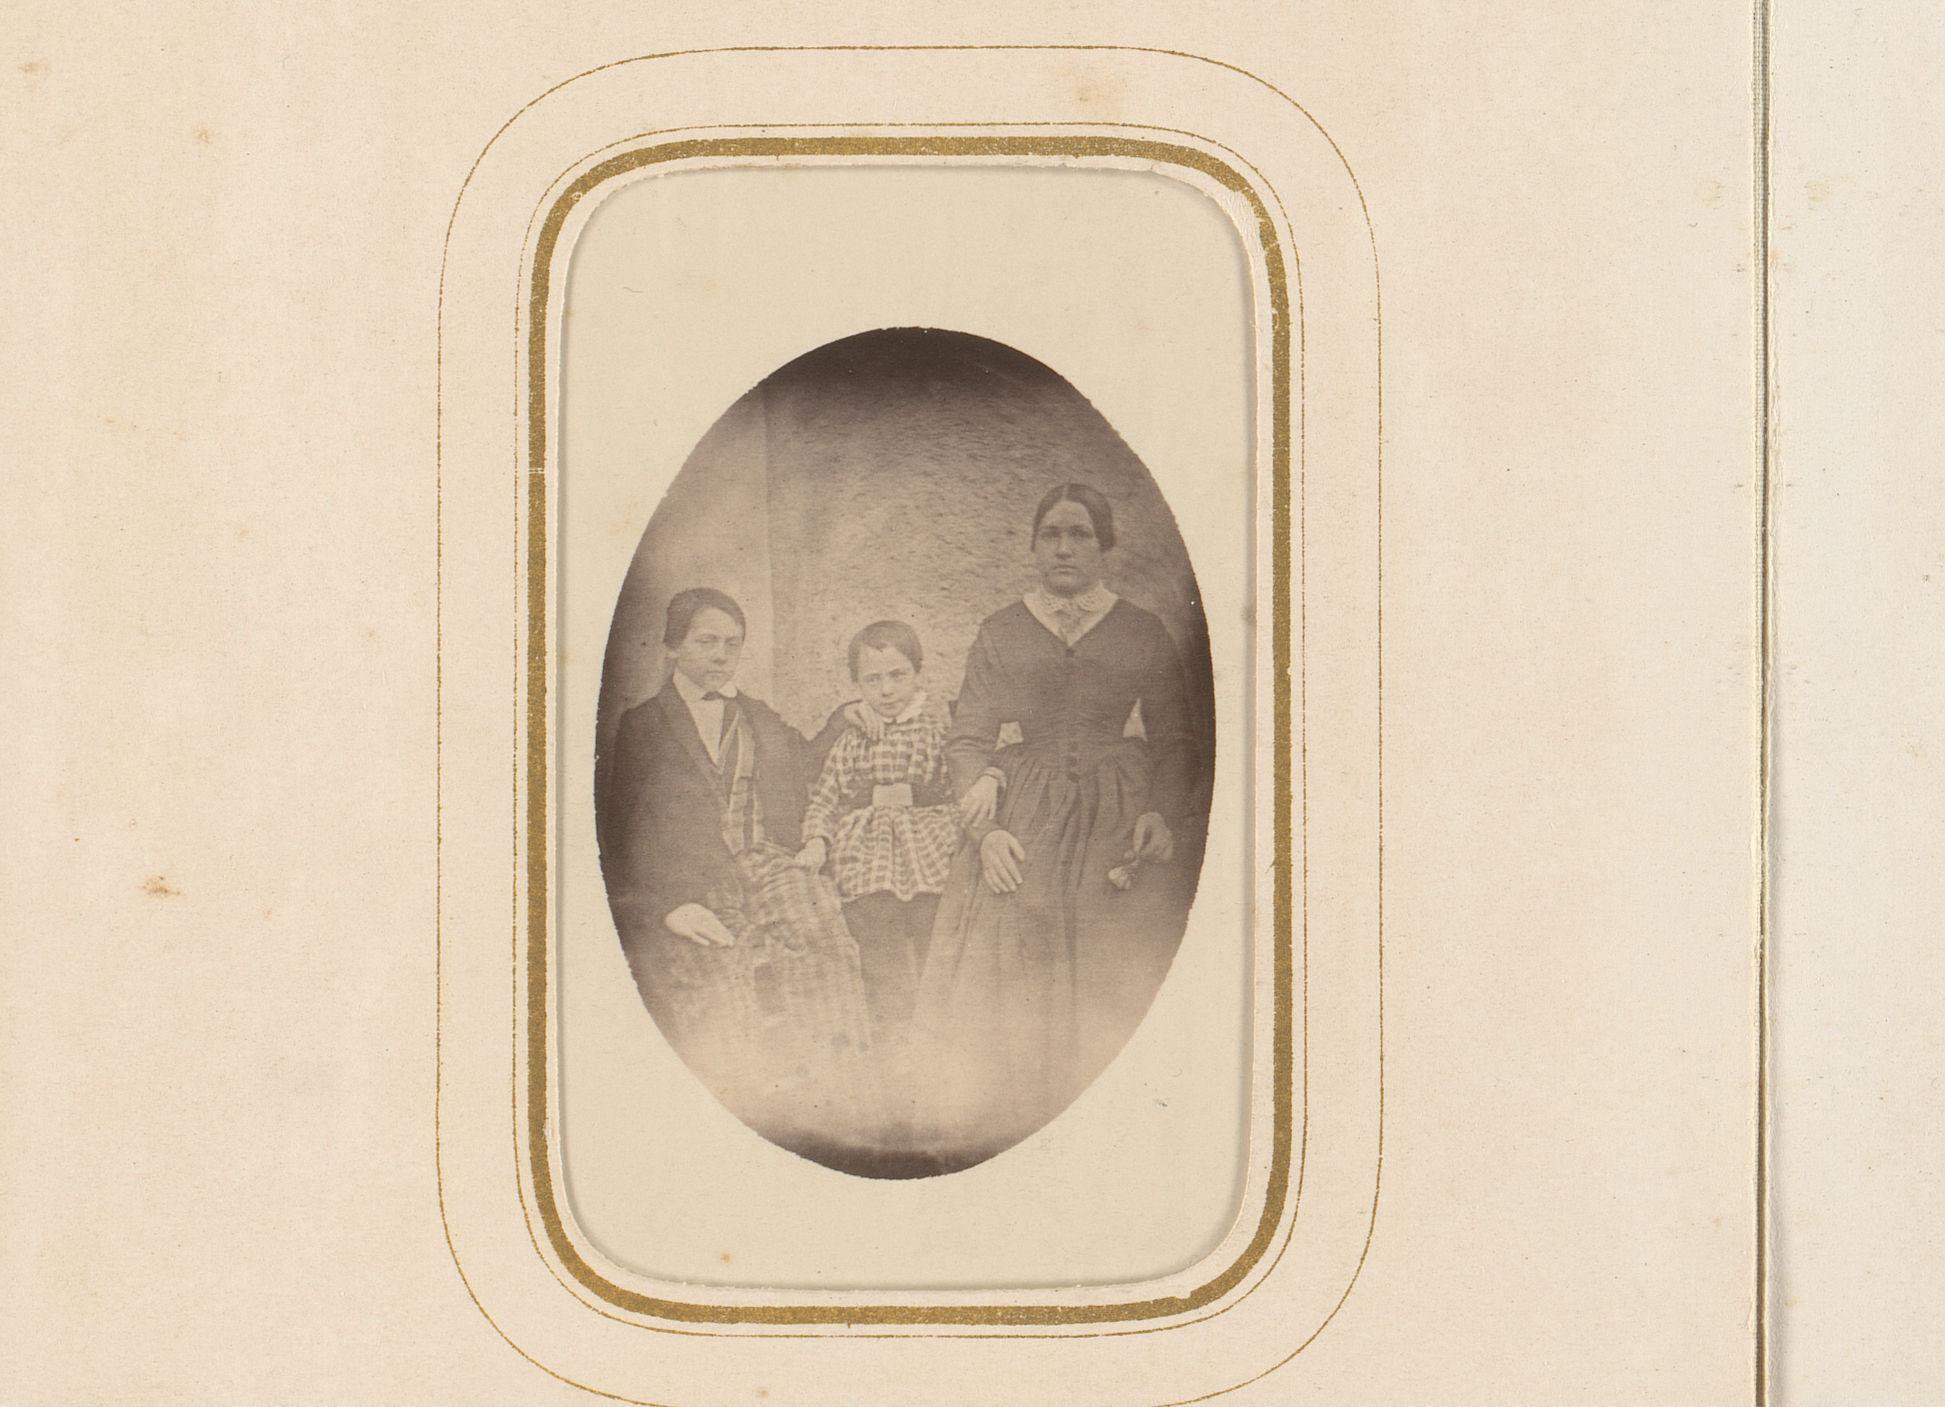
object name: album leaf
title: Groepsportret met moeder en twee kinderen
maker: benoît bonnet-poméon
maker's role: printer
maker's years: 1827-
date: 1860-1890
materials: cardboard, photographic support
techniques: albumen print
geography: rive-de-gier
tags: mother and child(ren), woman and child(ren) (family group)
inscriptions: inscription: ‘Photographie Artistique/ Bonnet-Poméon/ Rue de Lyon, 15/ Rive-de-Gier/ Loire’